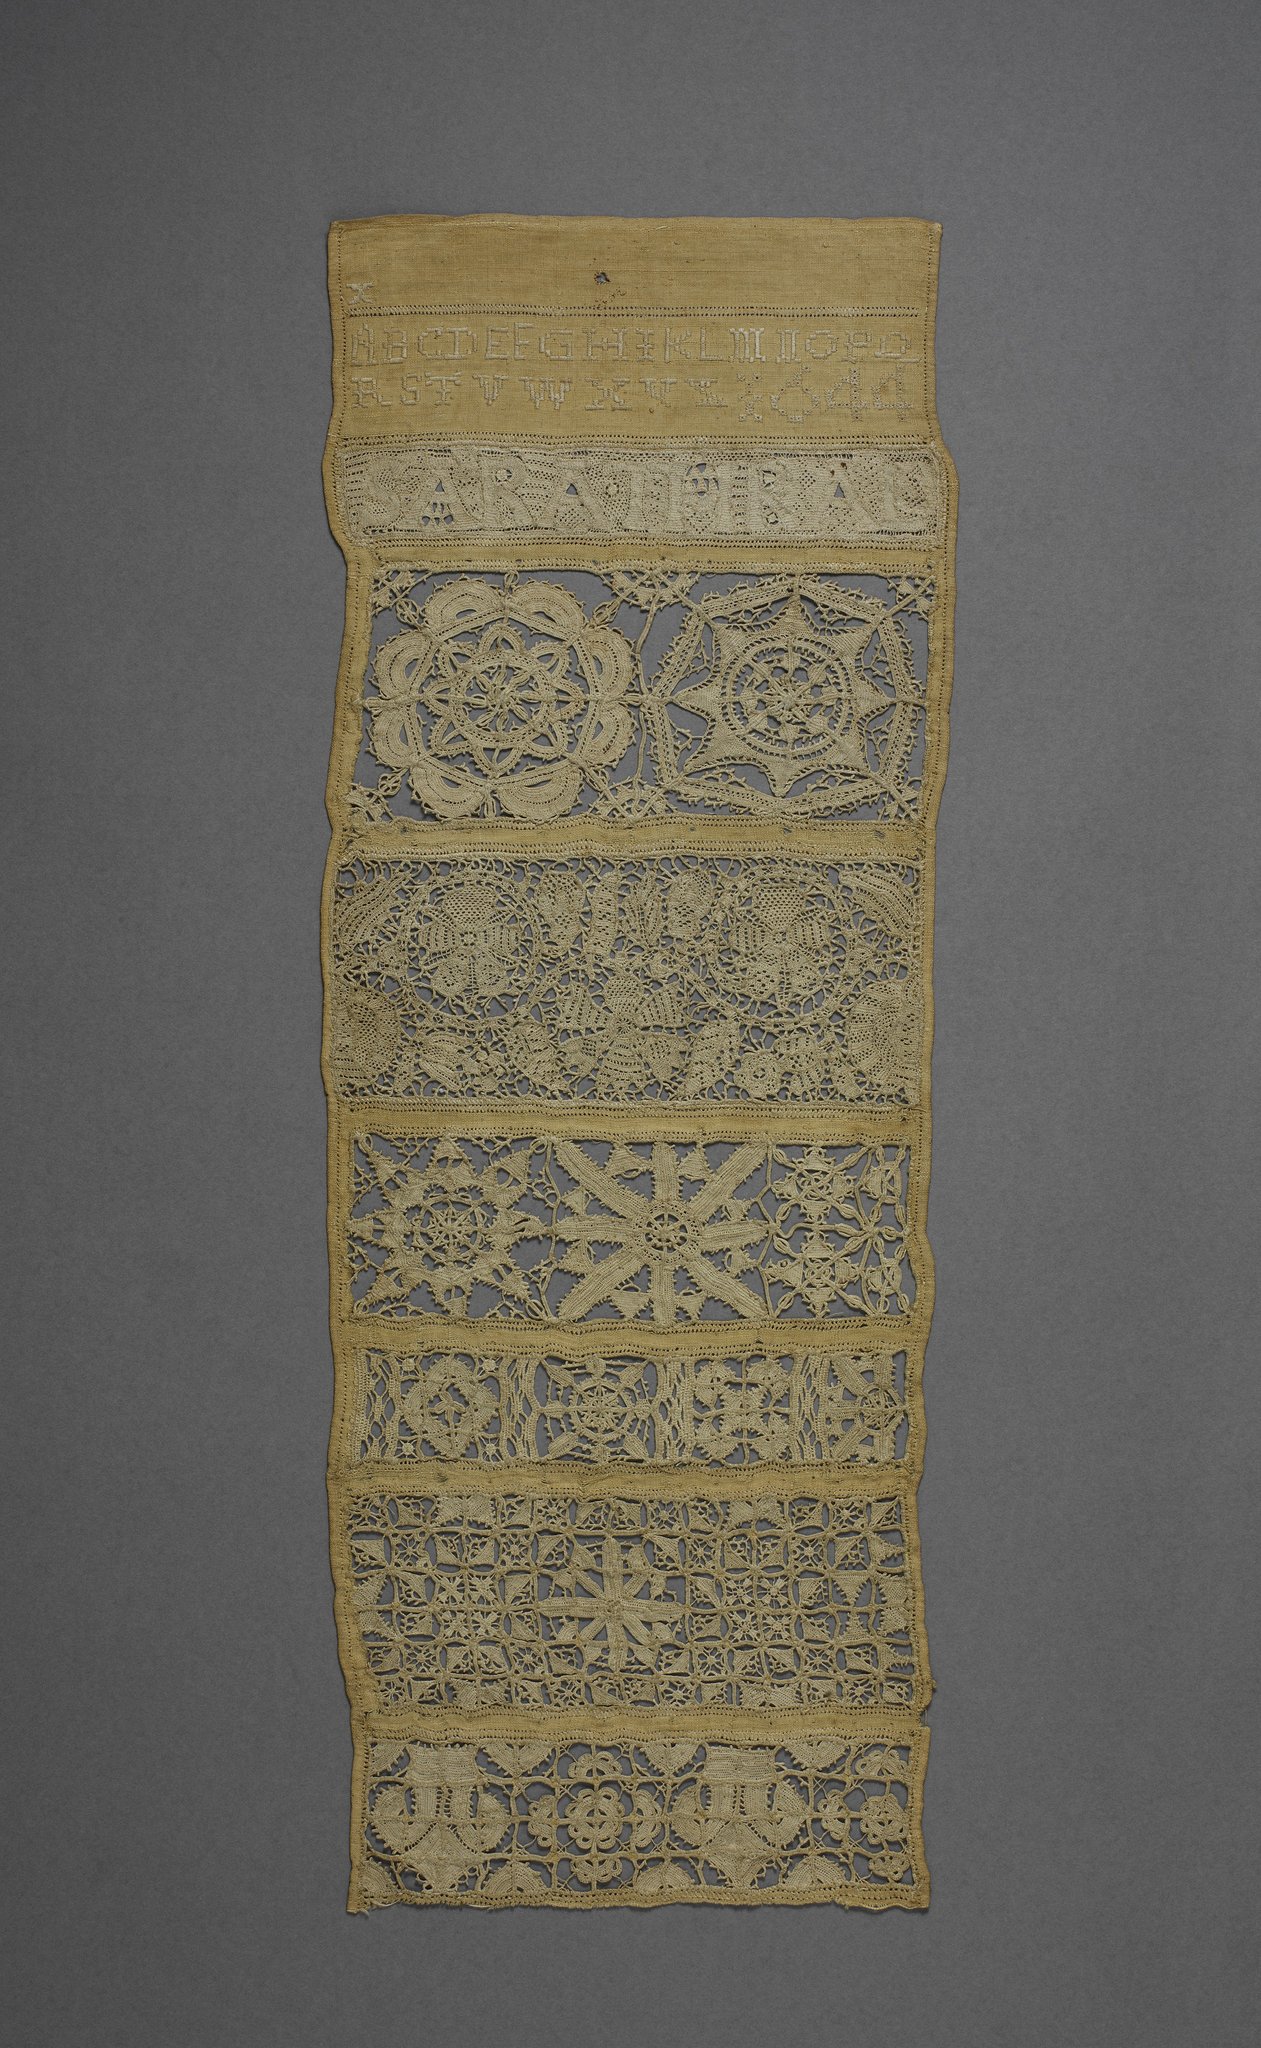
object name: sampler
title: Sampler with needle lace and cutwork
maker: sarah thral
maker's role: maker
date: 1644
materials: linen, textile, thread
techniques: embroidery, stitching